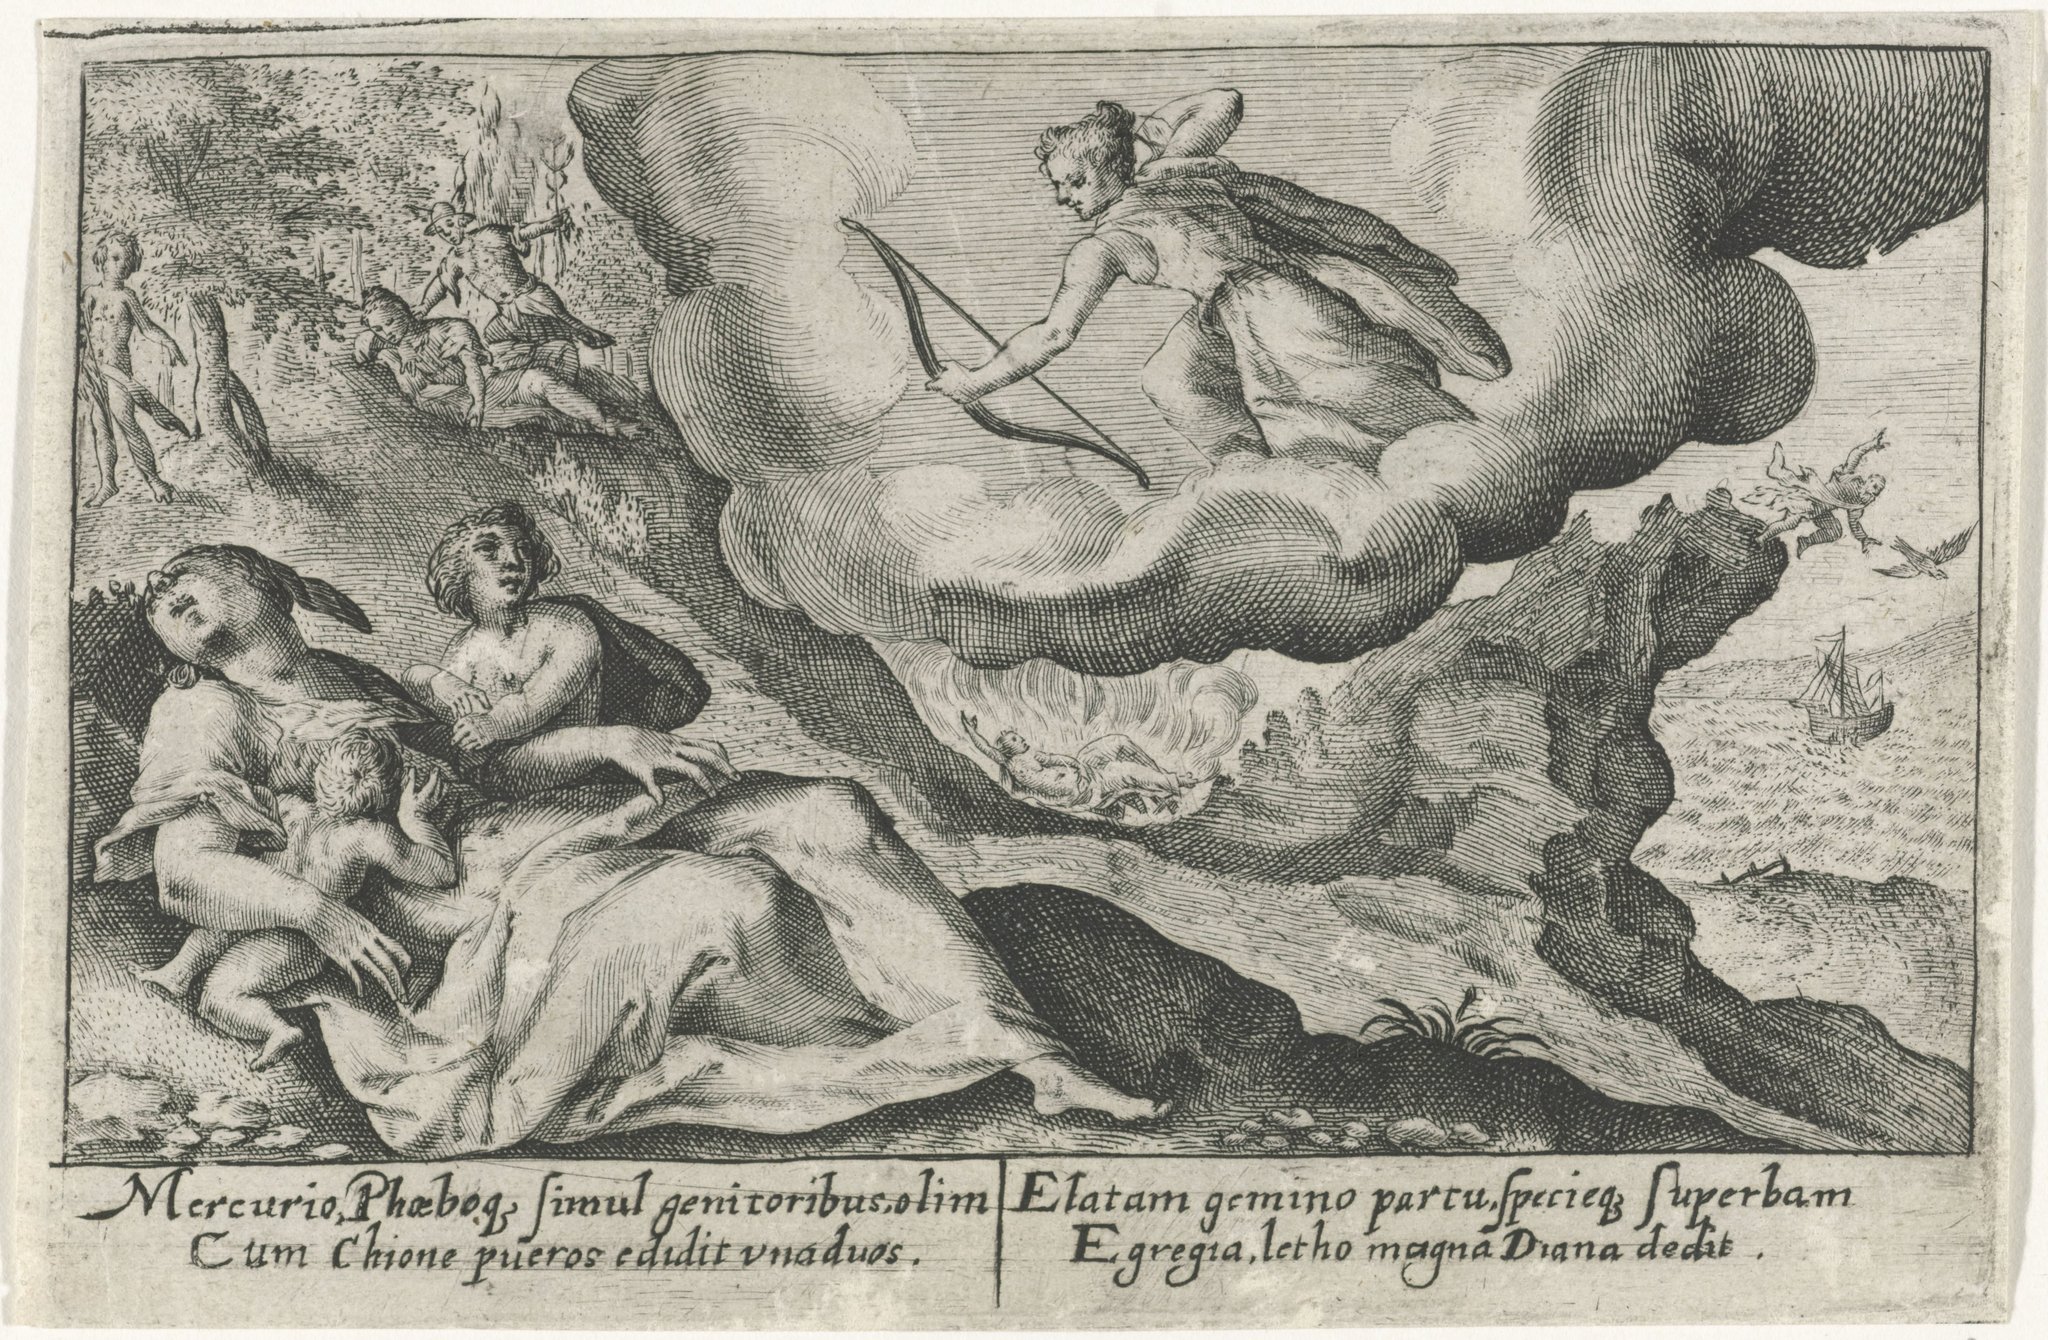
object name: print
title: Diana doodt Chione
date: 1602-1607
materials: paper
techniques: engraving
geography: cologne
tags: death of chione, daughter of daedalion: she is shot in the tongue by diana for comparing her own beauty with that of the goddess, daedalion changed into a hawk: while leaping from a cliff, crazed by the death of his daughter chione, daedalion is changed into a hawk by apollo (ovid, metamorphoses xi 339), mercury wooing chione; apollo present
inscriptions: collector's mark: Lugt 2228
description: Chione wordt door Diana doodgeschoten. De twee kinderen die zij kreeg van Apollo en Mercurius, die allebei verliefd op haar waren, kijken toe. Linksachter Mercurius die met zijn staf langs Chione's ogen strijkt, waarop zij in slaap valt. Rechts op de achtergrond Daedalion, de vader van Chione, die van de Parnassus spingt en door Apollo in een vogel wordt veranderd. In de marge een vierregelig onderschrift, in twee kolommen, in het Latijn.